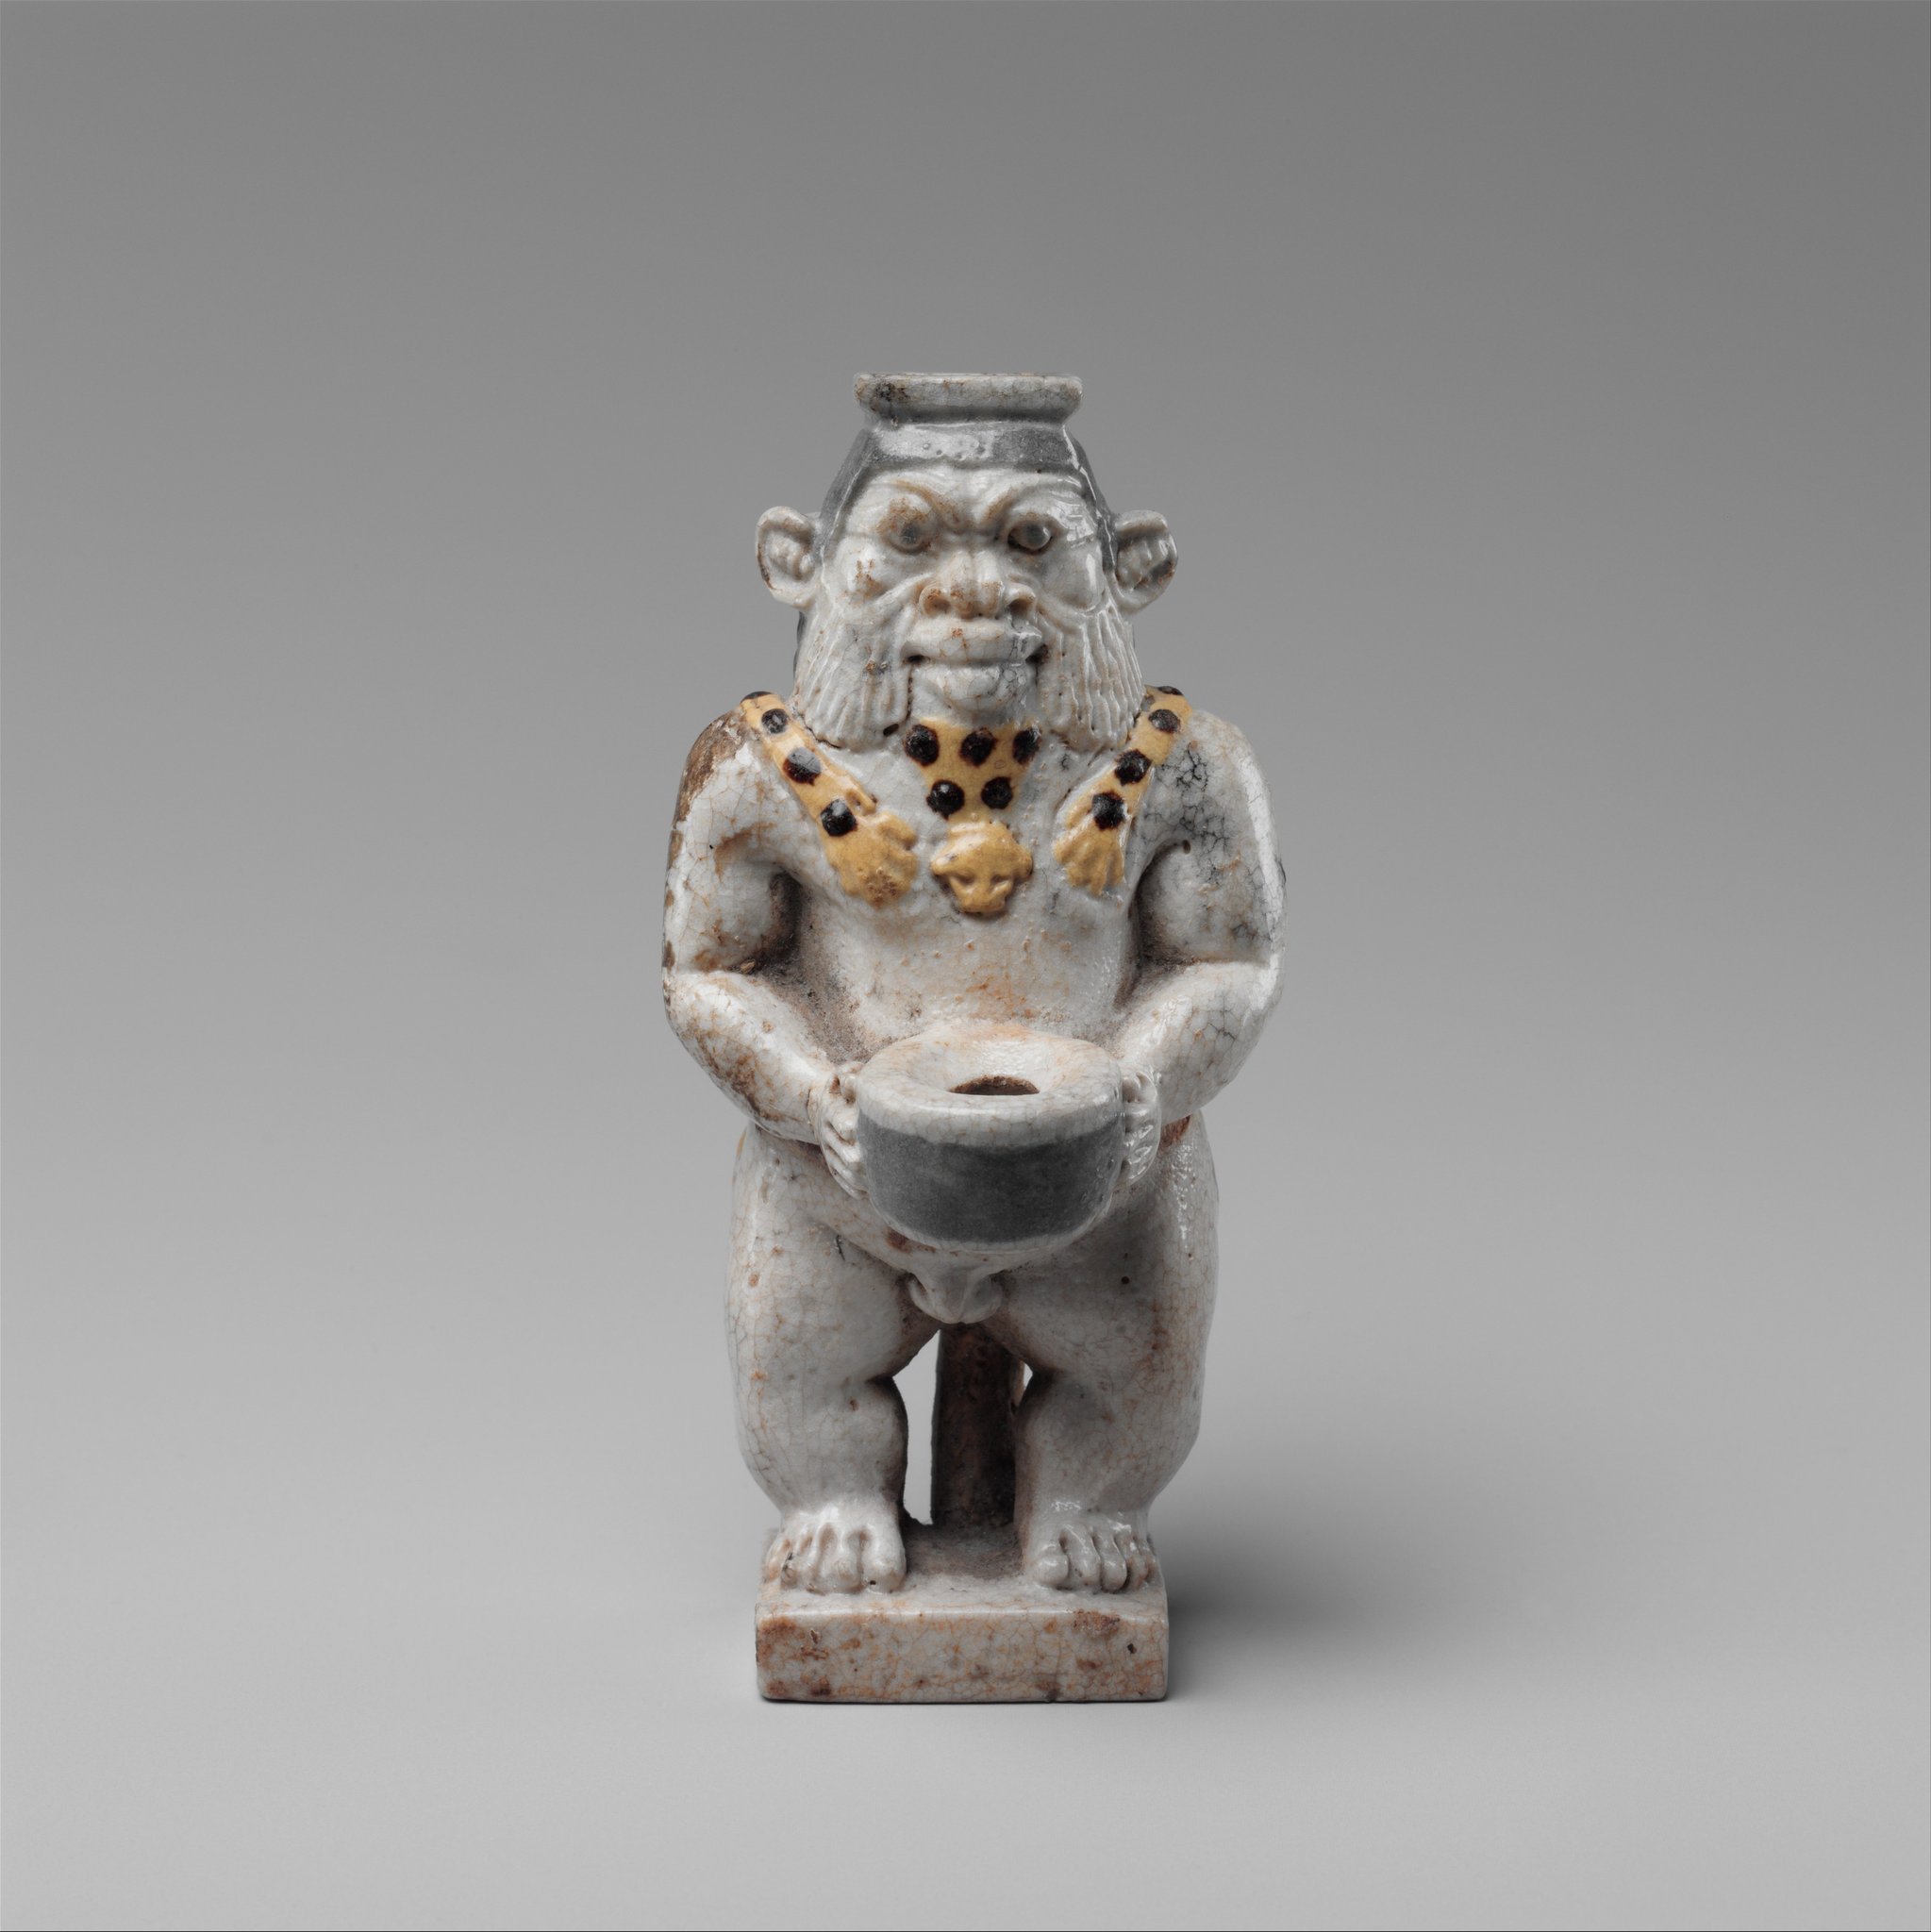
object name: kohl container, be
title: Container in the form of a Bes-image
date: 525-404 BCE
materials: faience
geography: egypt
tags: bes